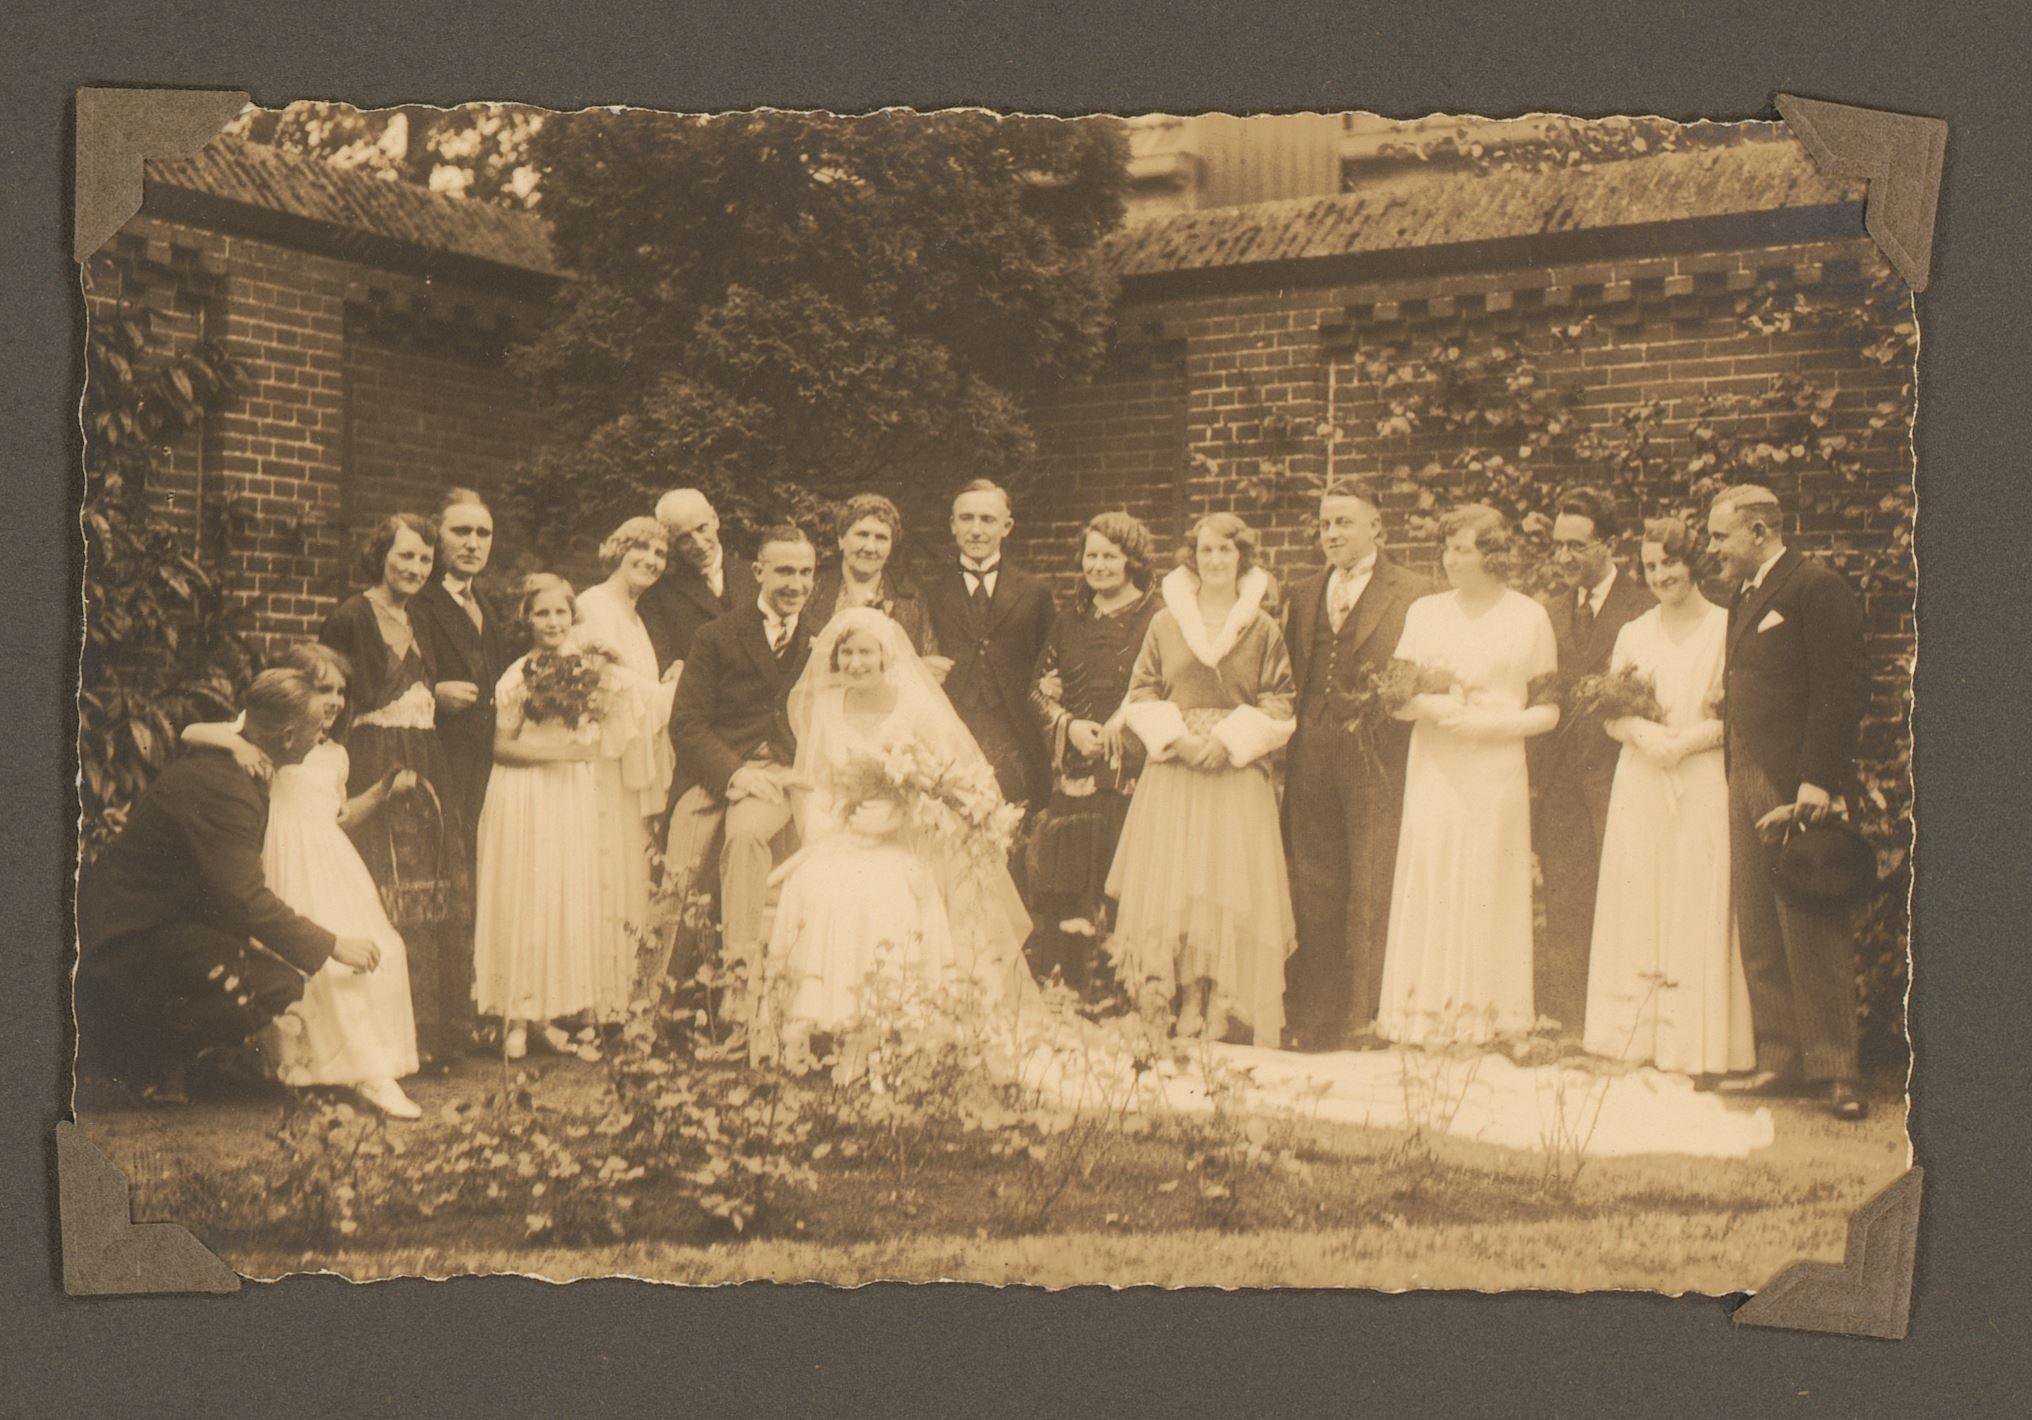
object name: album leaf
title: Groepsportret ter ere van een bruiloft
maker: Anonymous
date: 1920-1940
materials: photographic support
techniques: gelatin silver print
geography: netherlands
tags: visiting; receiving guests; elegant company, members of bridal party